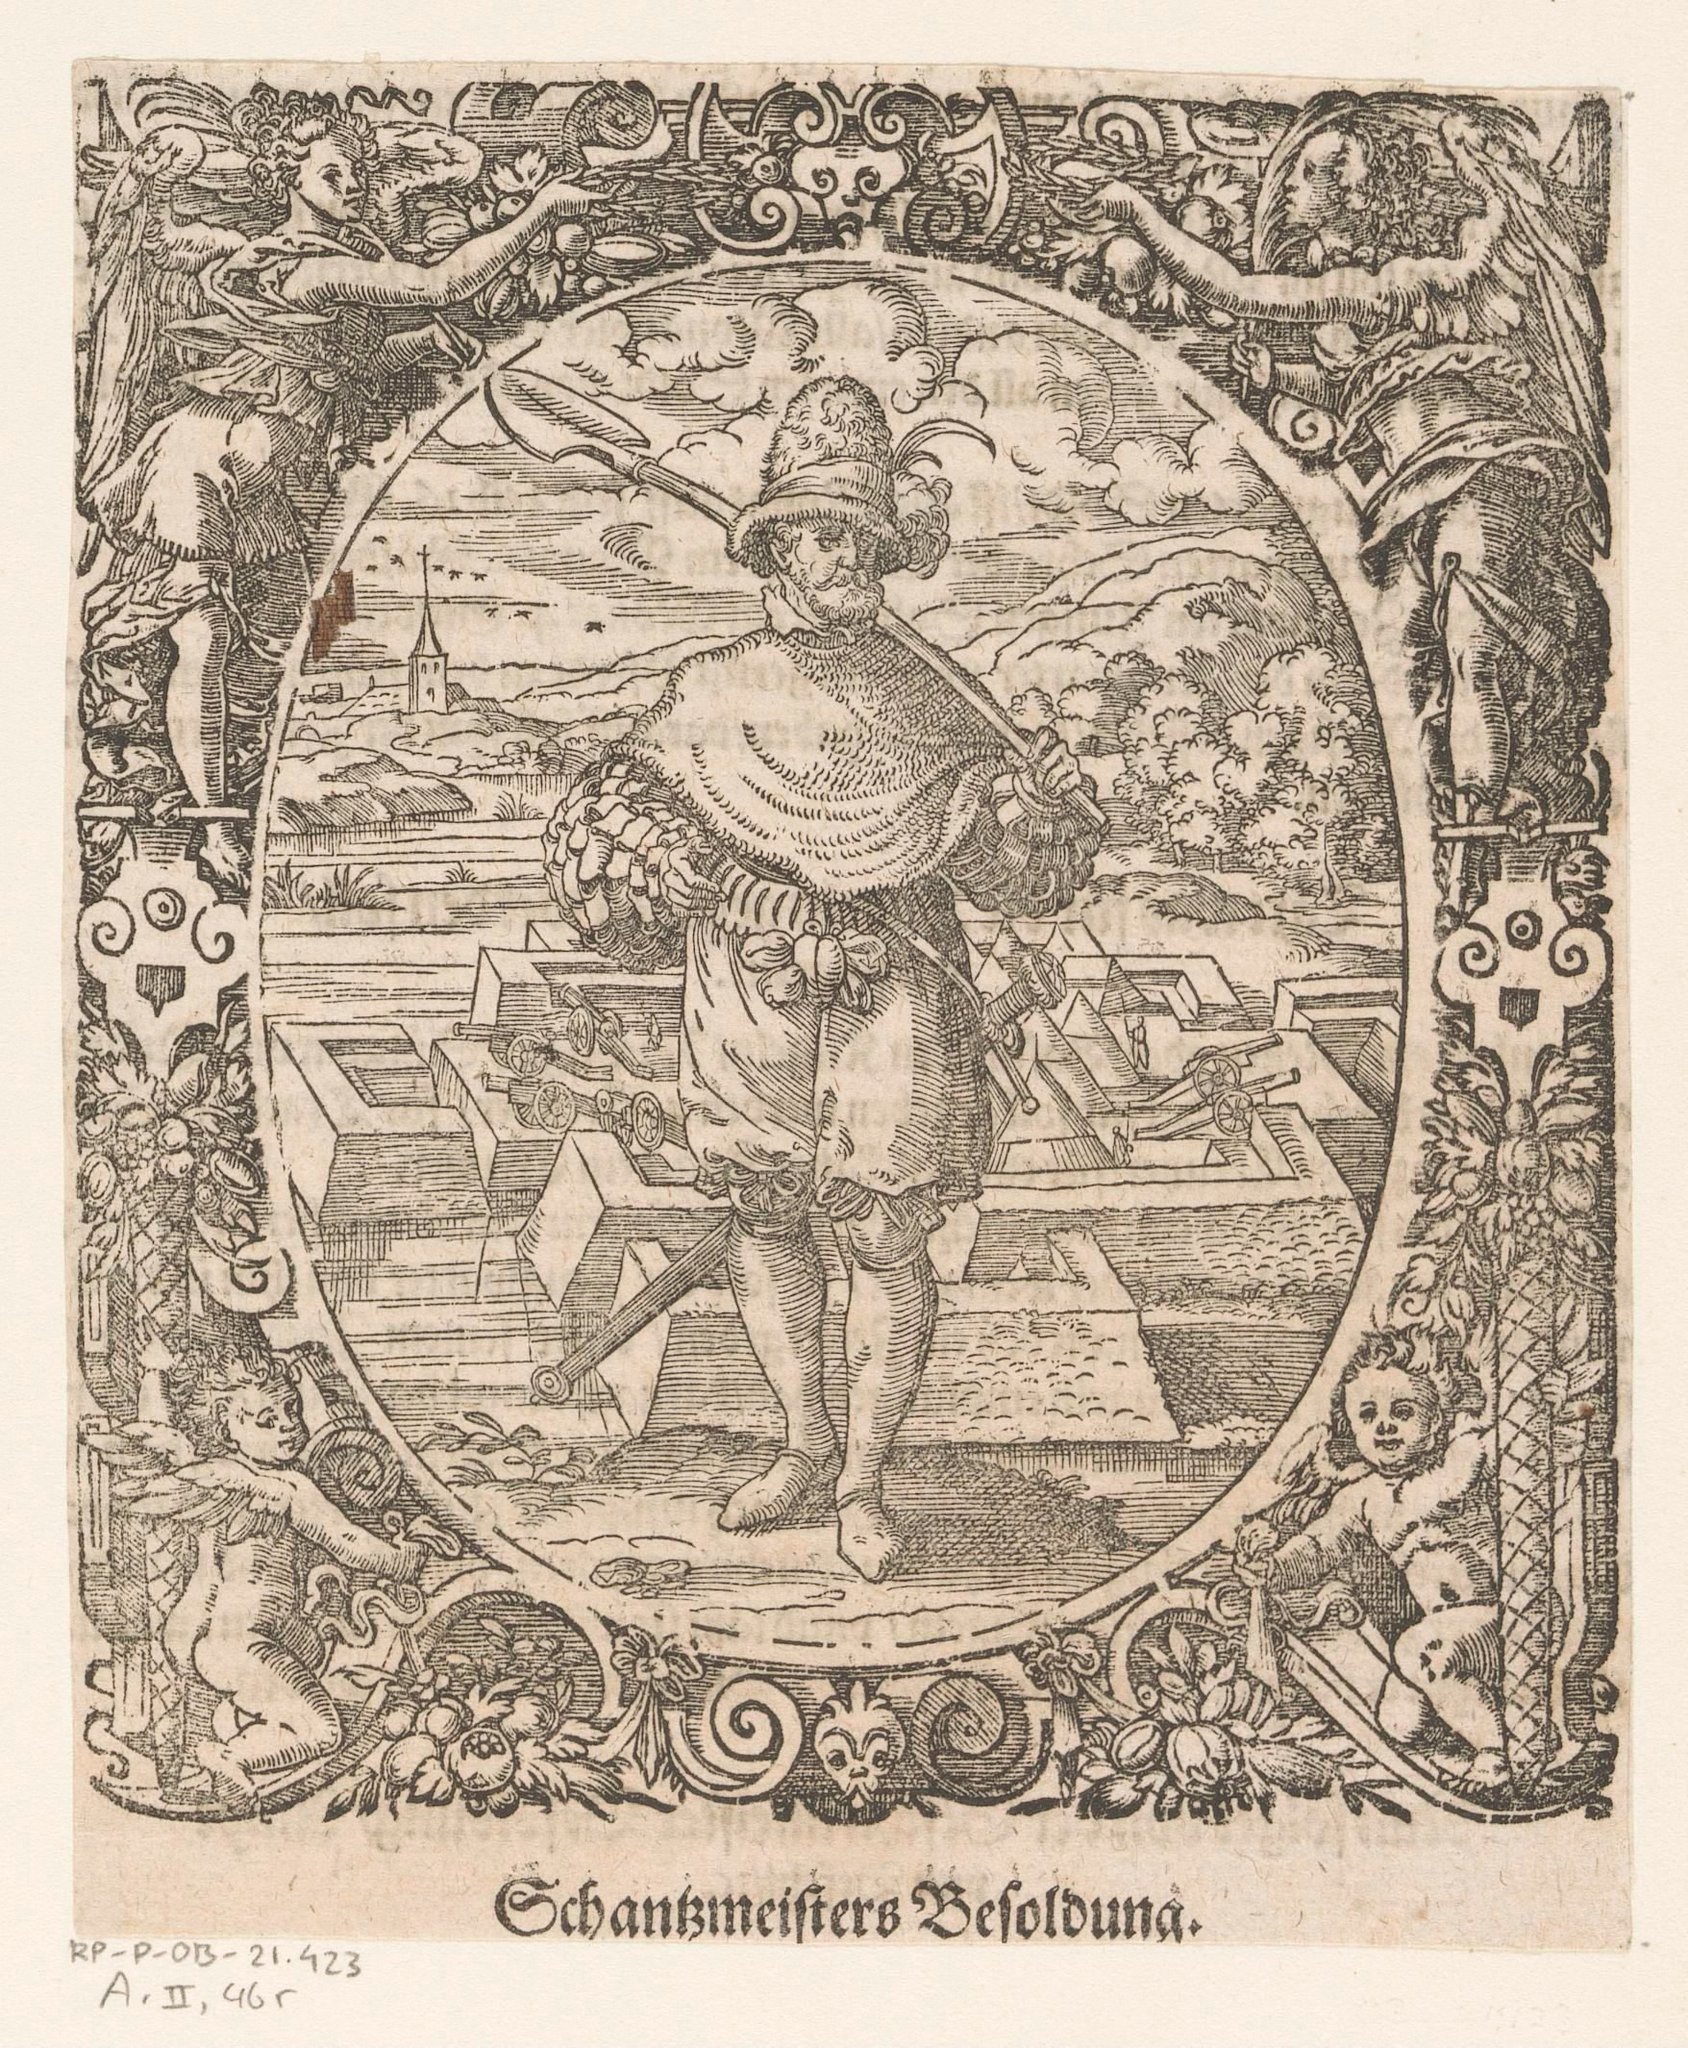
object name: print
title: Militair bij een ommuurd tentenkamp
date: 1573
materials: paper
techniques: woodcut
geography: nuremberg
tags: firearms: cannon, warfare; military affairs, the soldier; the soldier's life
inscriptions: collector's mark: Lugt 240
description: Zowel de voorstelling als de ornamentrand werd gebruikt voor verschillende edities van Leonhardt Fronspergers Kriegsbuch.